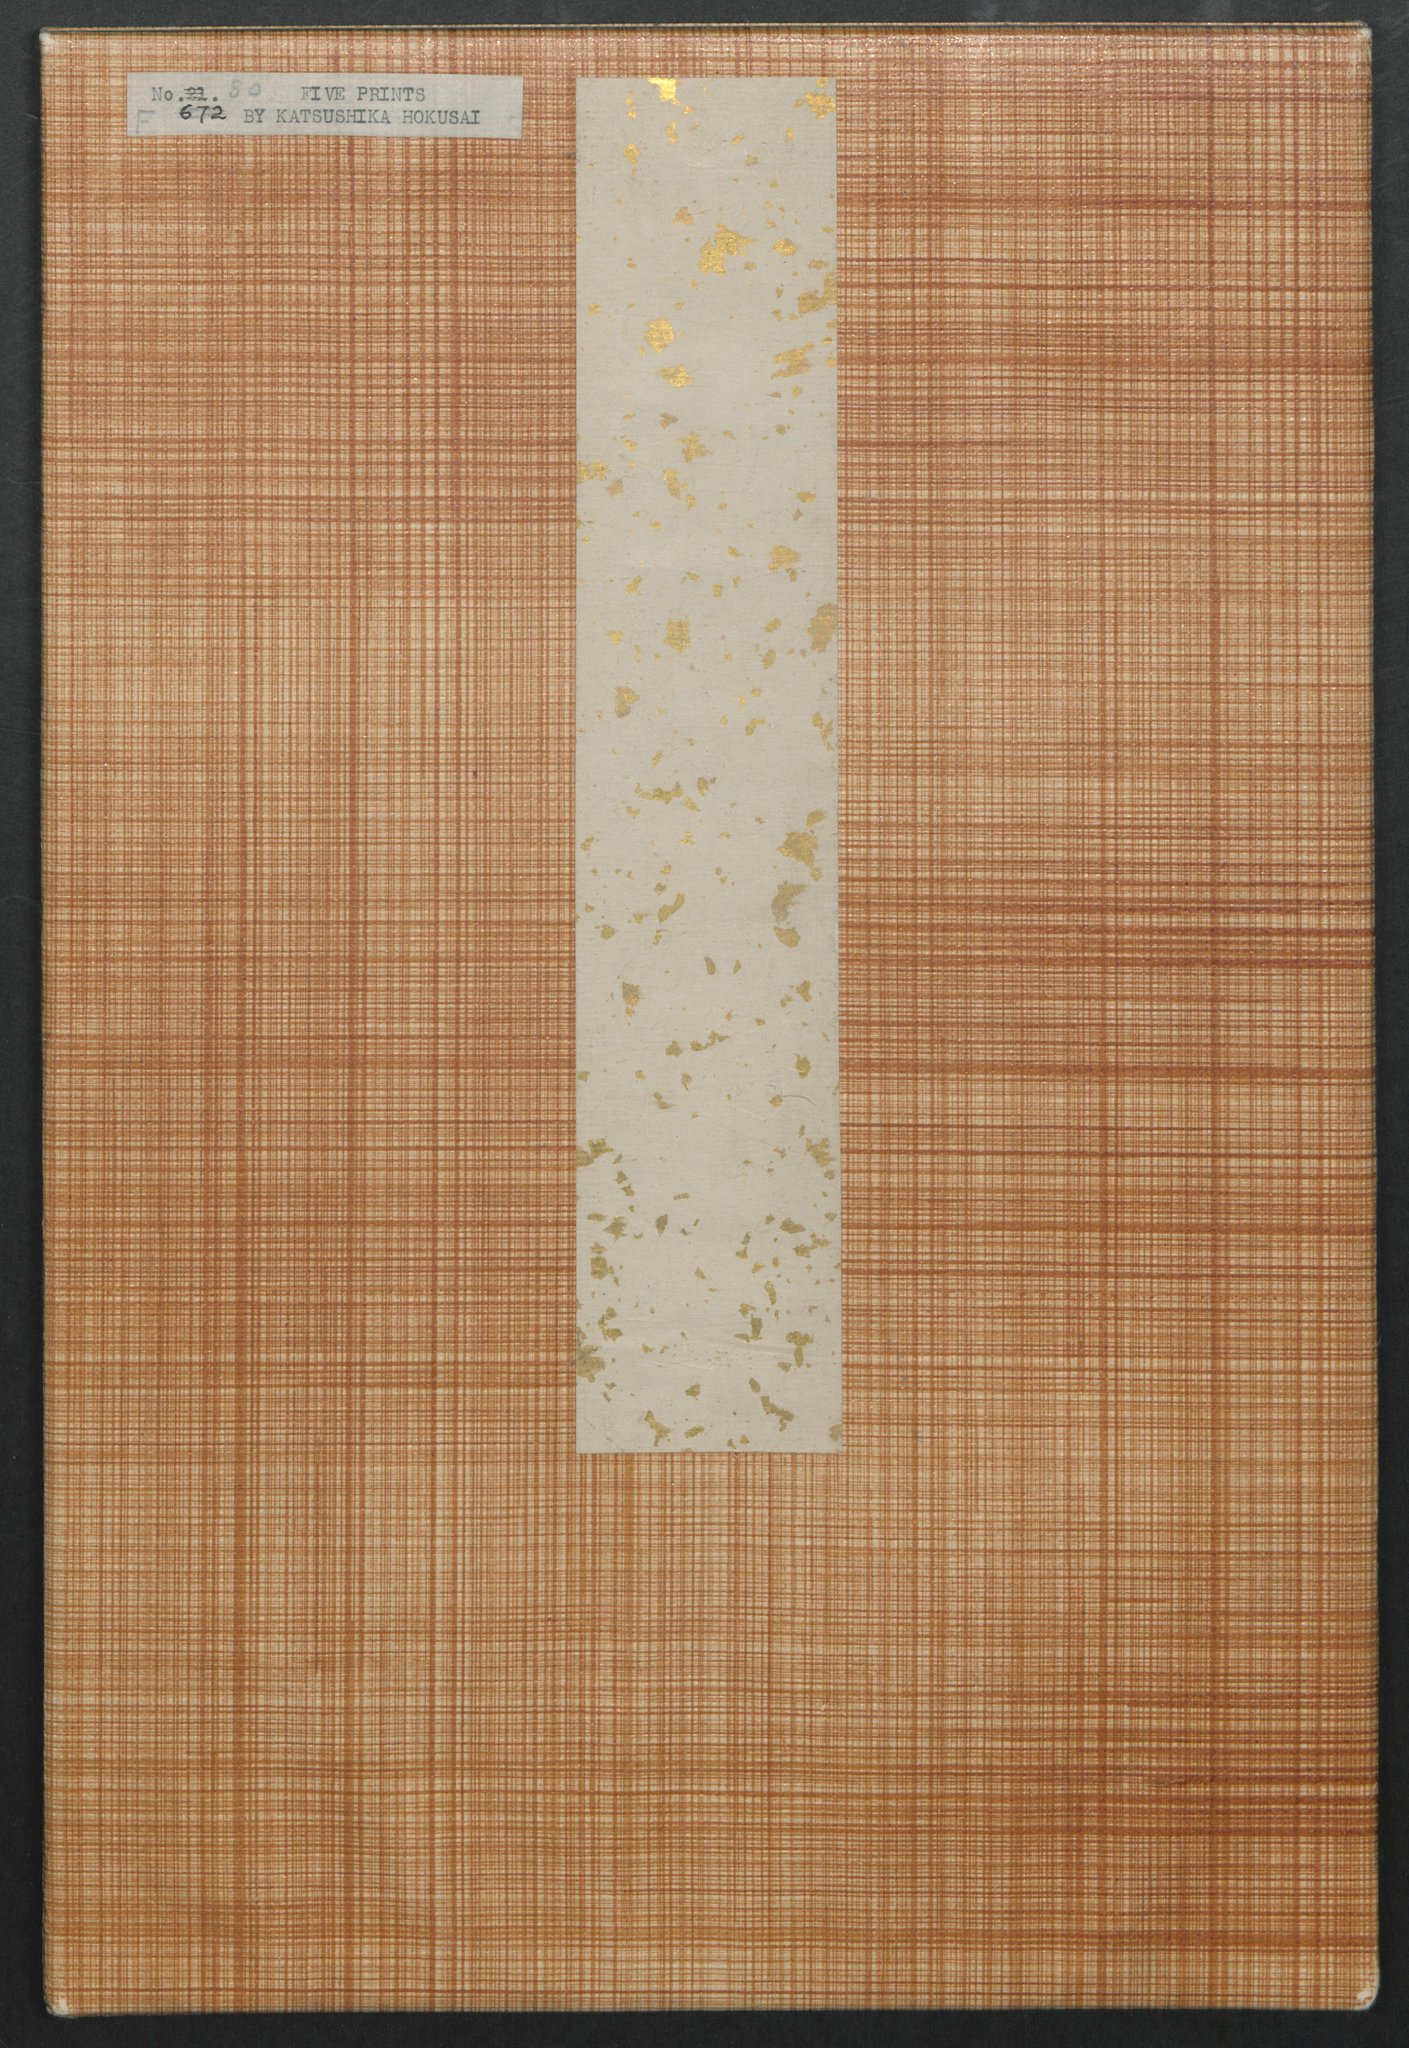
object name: illustrated book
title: New Year's Day at the Ogiya Seiro (Yoshiwara yūkaku no kei) 吉原遊郭の景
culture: japanese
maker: katsushika hokusai 葛飾北斎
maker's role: artist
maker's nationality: japanese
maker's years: 1760-1849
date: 1804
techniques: polychrome, woodblock print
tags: interiors,men,women